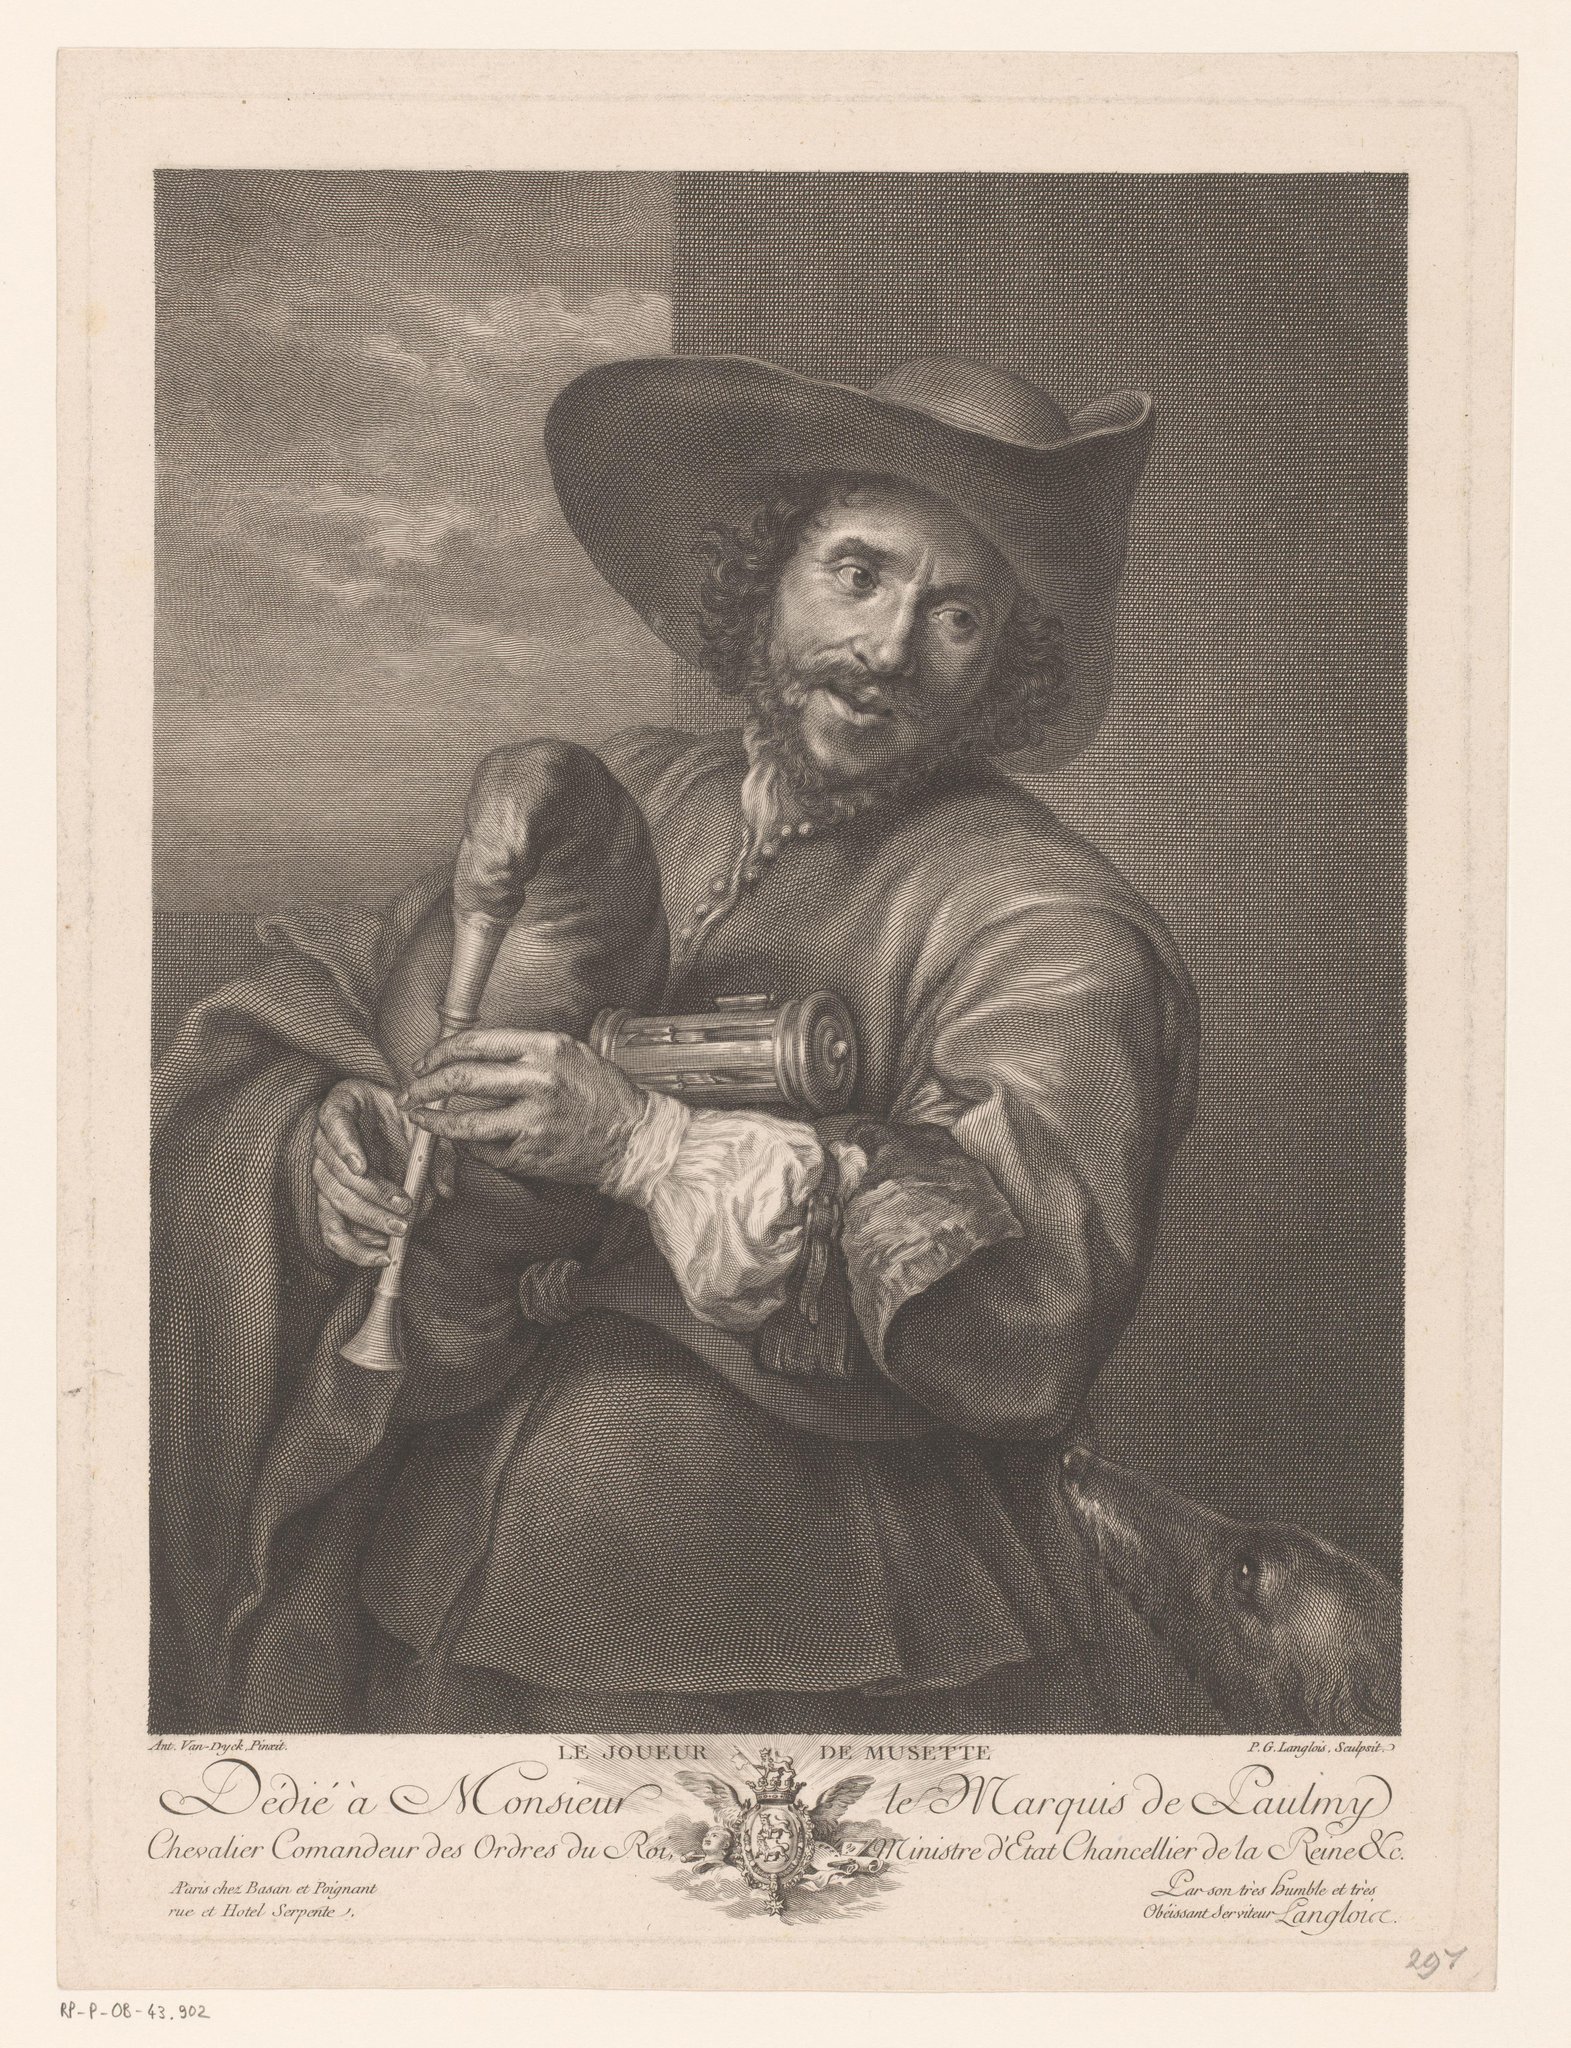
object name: print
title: Le Joueur de Musette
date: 1764-1788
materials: paper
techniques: engraving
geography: france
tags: paris, print maker, publisher, françois langlois, bagpipe, musette, historical persons, portrait, self-portrait of artist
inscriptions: collector's mark: Lugt 2228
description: Het schilderij door Van Dyck bevindt zich in de collectie van The National Gallery te Londen, inv.nr. NG6567.